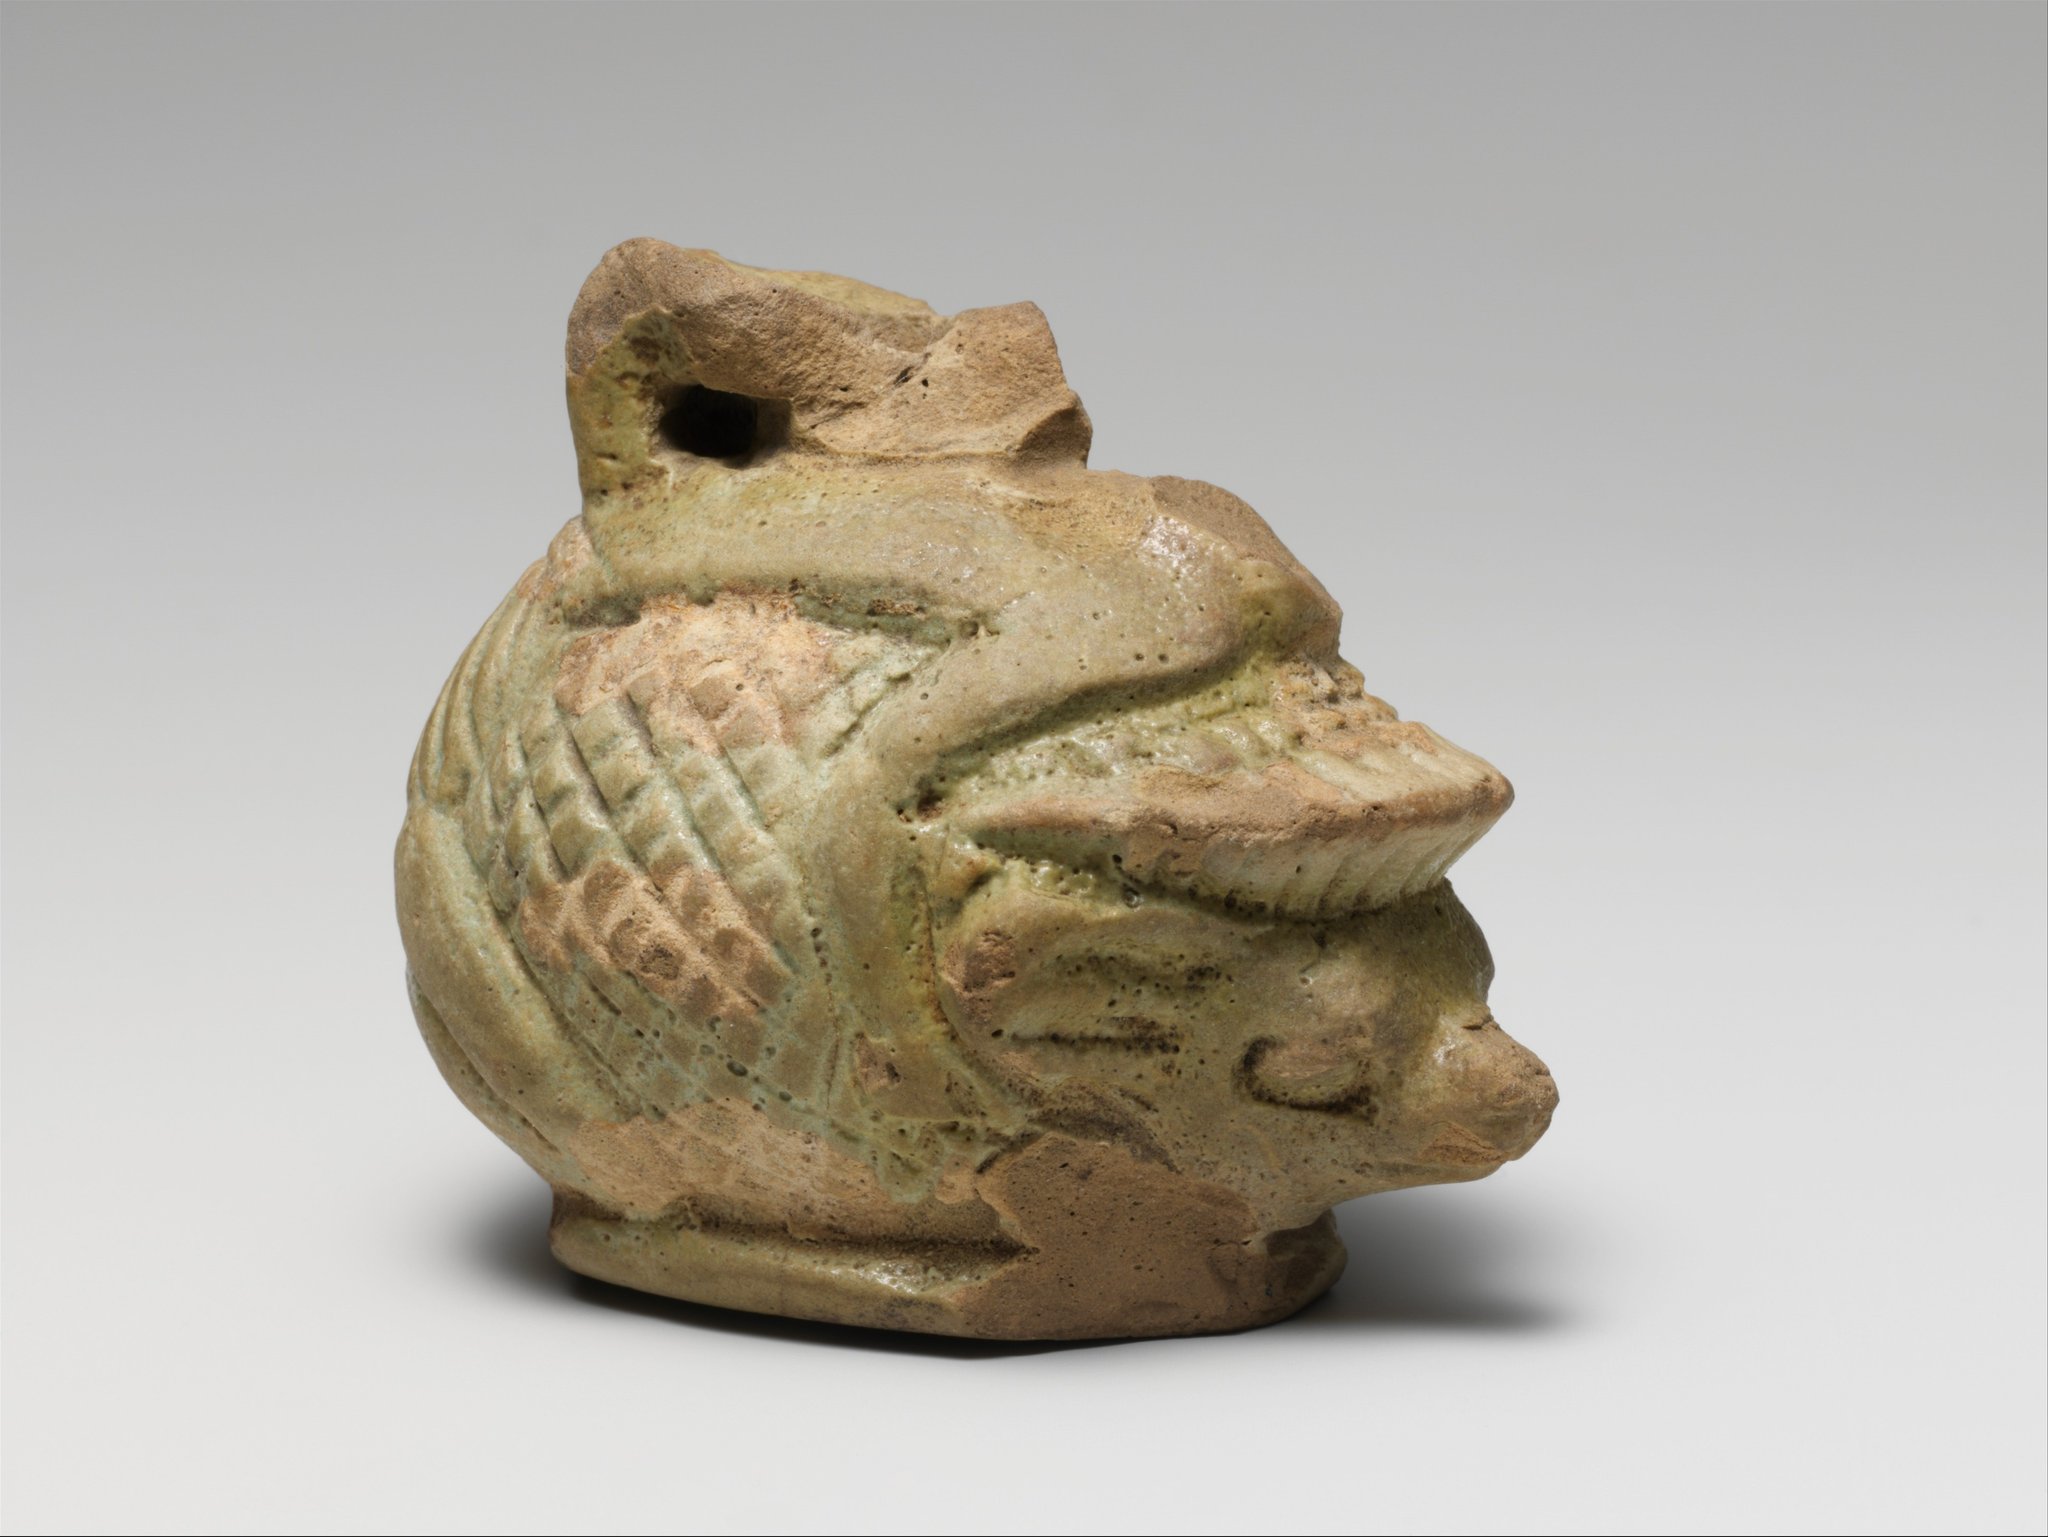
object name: aryballos in the form of a man crouching on a hedge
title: Faience aryballos (oil bottle) in the form of a hedgehog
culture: east greek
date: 600-501 BCE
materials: faience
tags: animals